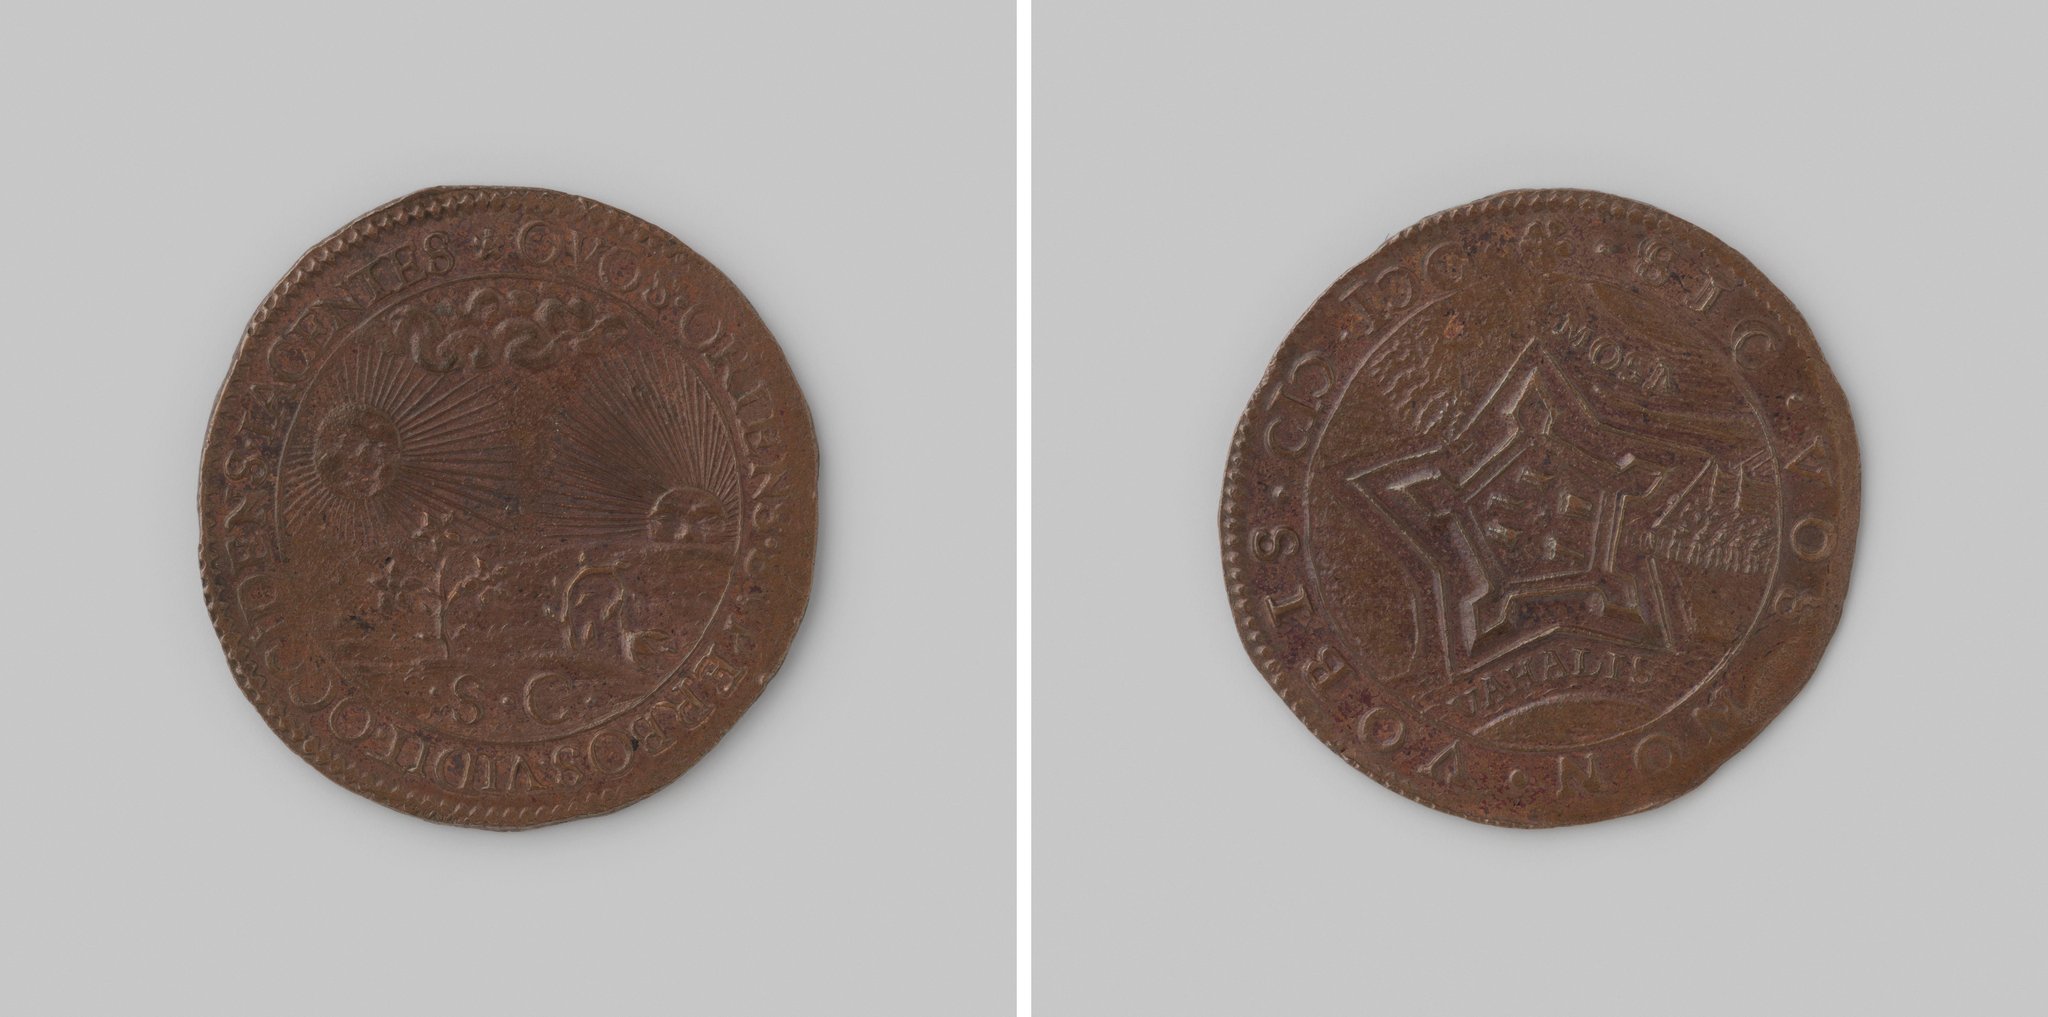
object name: jeton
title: Rekenpenning uit Dordrecht op de inname van Fort Sint Andries bij Heerewaarden 1600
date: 1600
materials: copper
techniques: striking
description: Koperen penning, op de voorzijde twee bloemen, één groeiend bij opgaande en één kwijnend bij ondergaande zon, met omschrift, op de keerzijde een plattegrond van het fort tussen Maas en Waal, met omschrift.